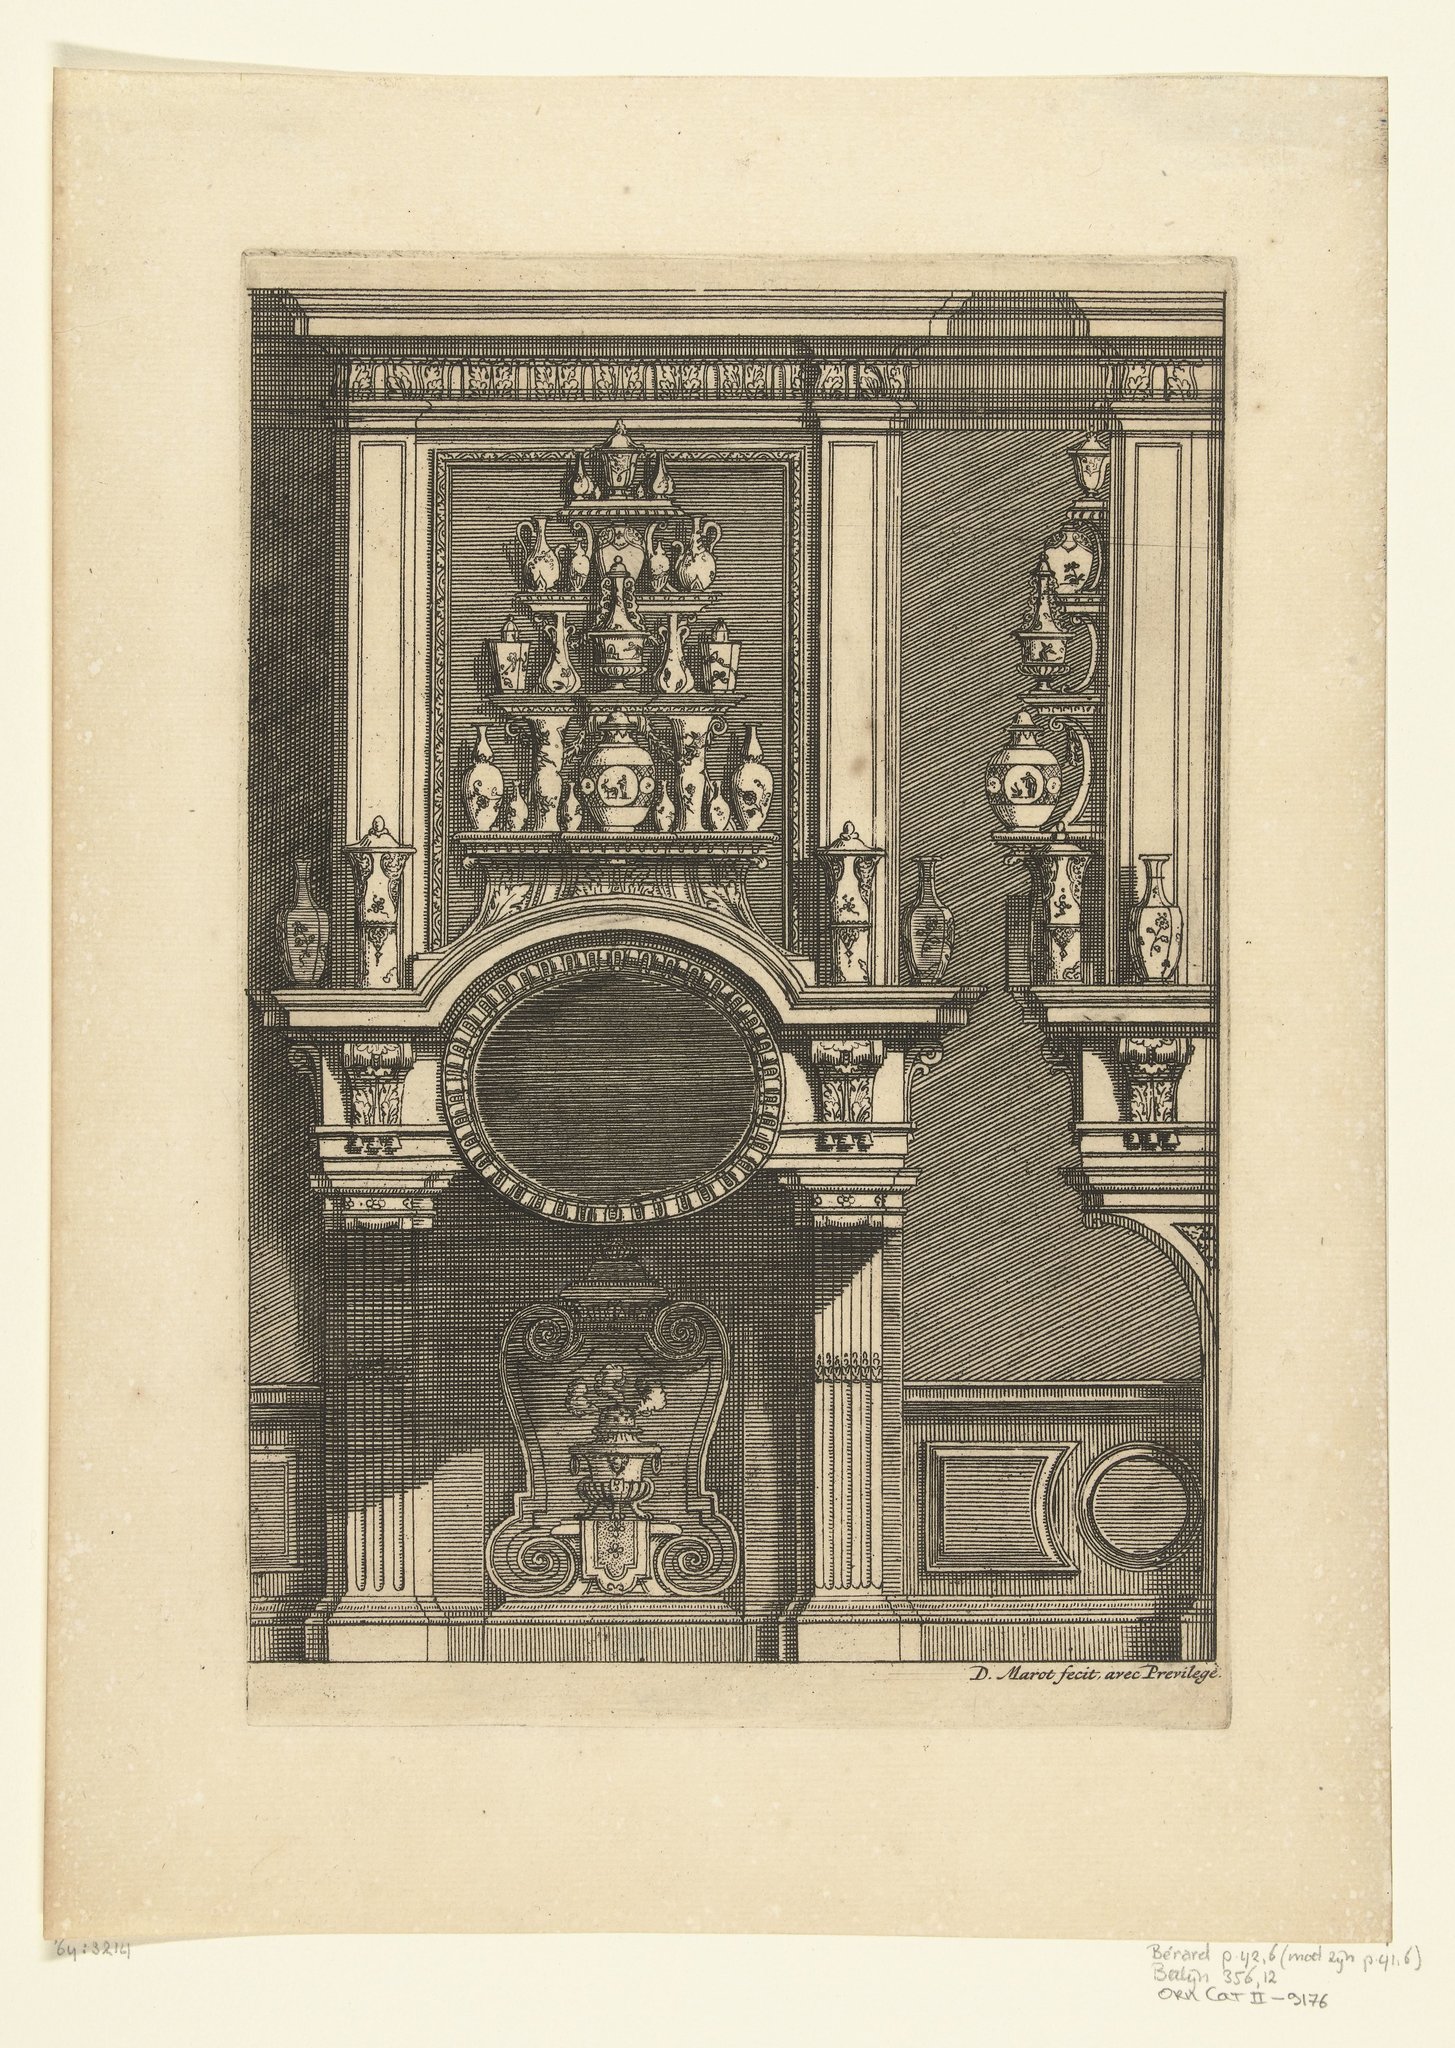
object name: ornament print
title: Onderboezem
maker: daniël marot (i)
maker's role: draughtsman, print maker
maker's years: 1661-1752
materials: paper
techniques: etching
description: De schoorsteenboezem bestaat uit twee lange consoles met daarboven een spiegel en een etagère met Chinese vazen en kannen. Uit serie van 6 bladen.